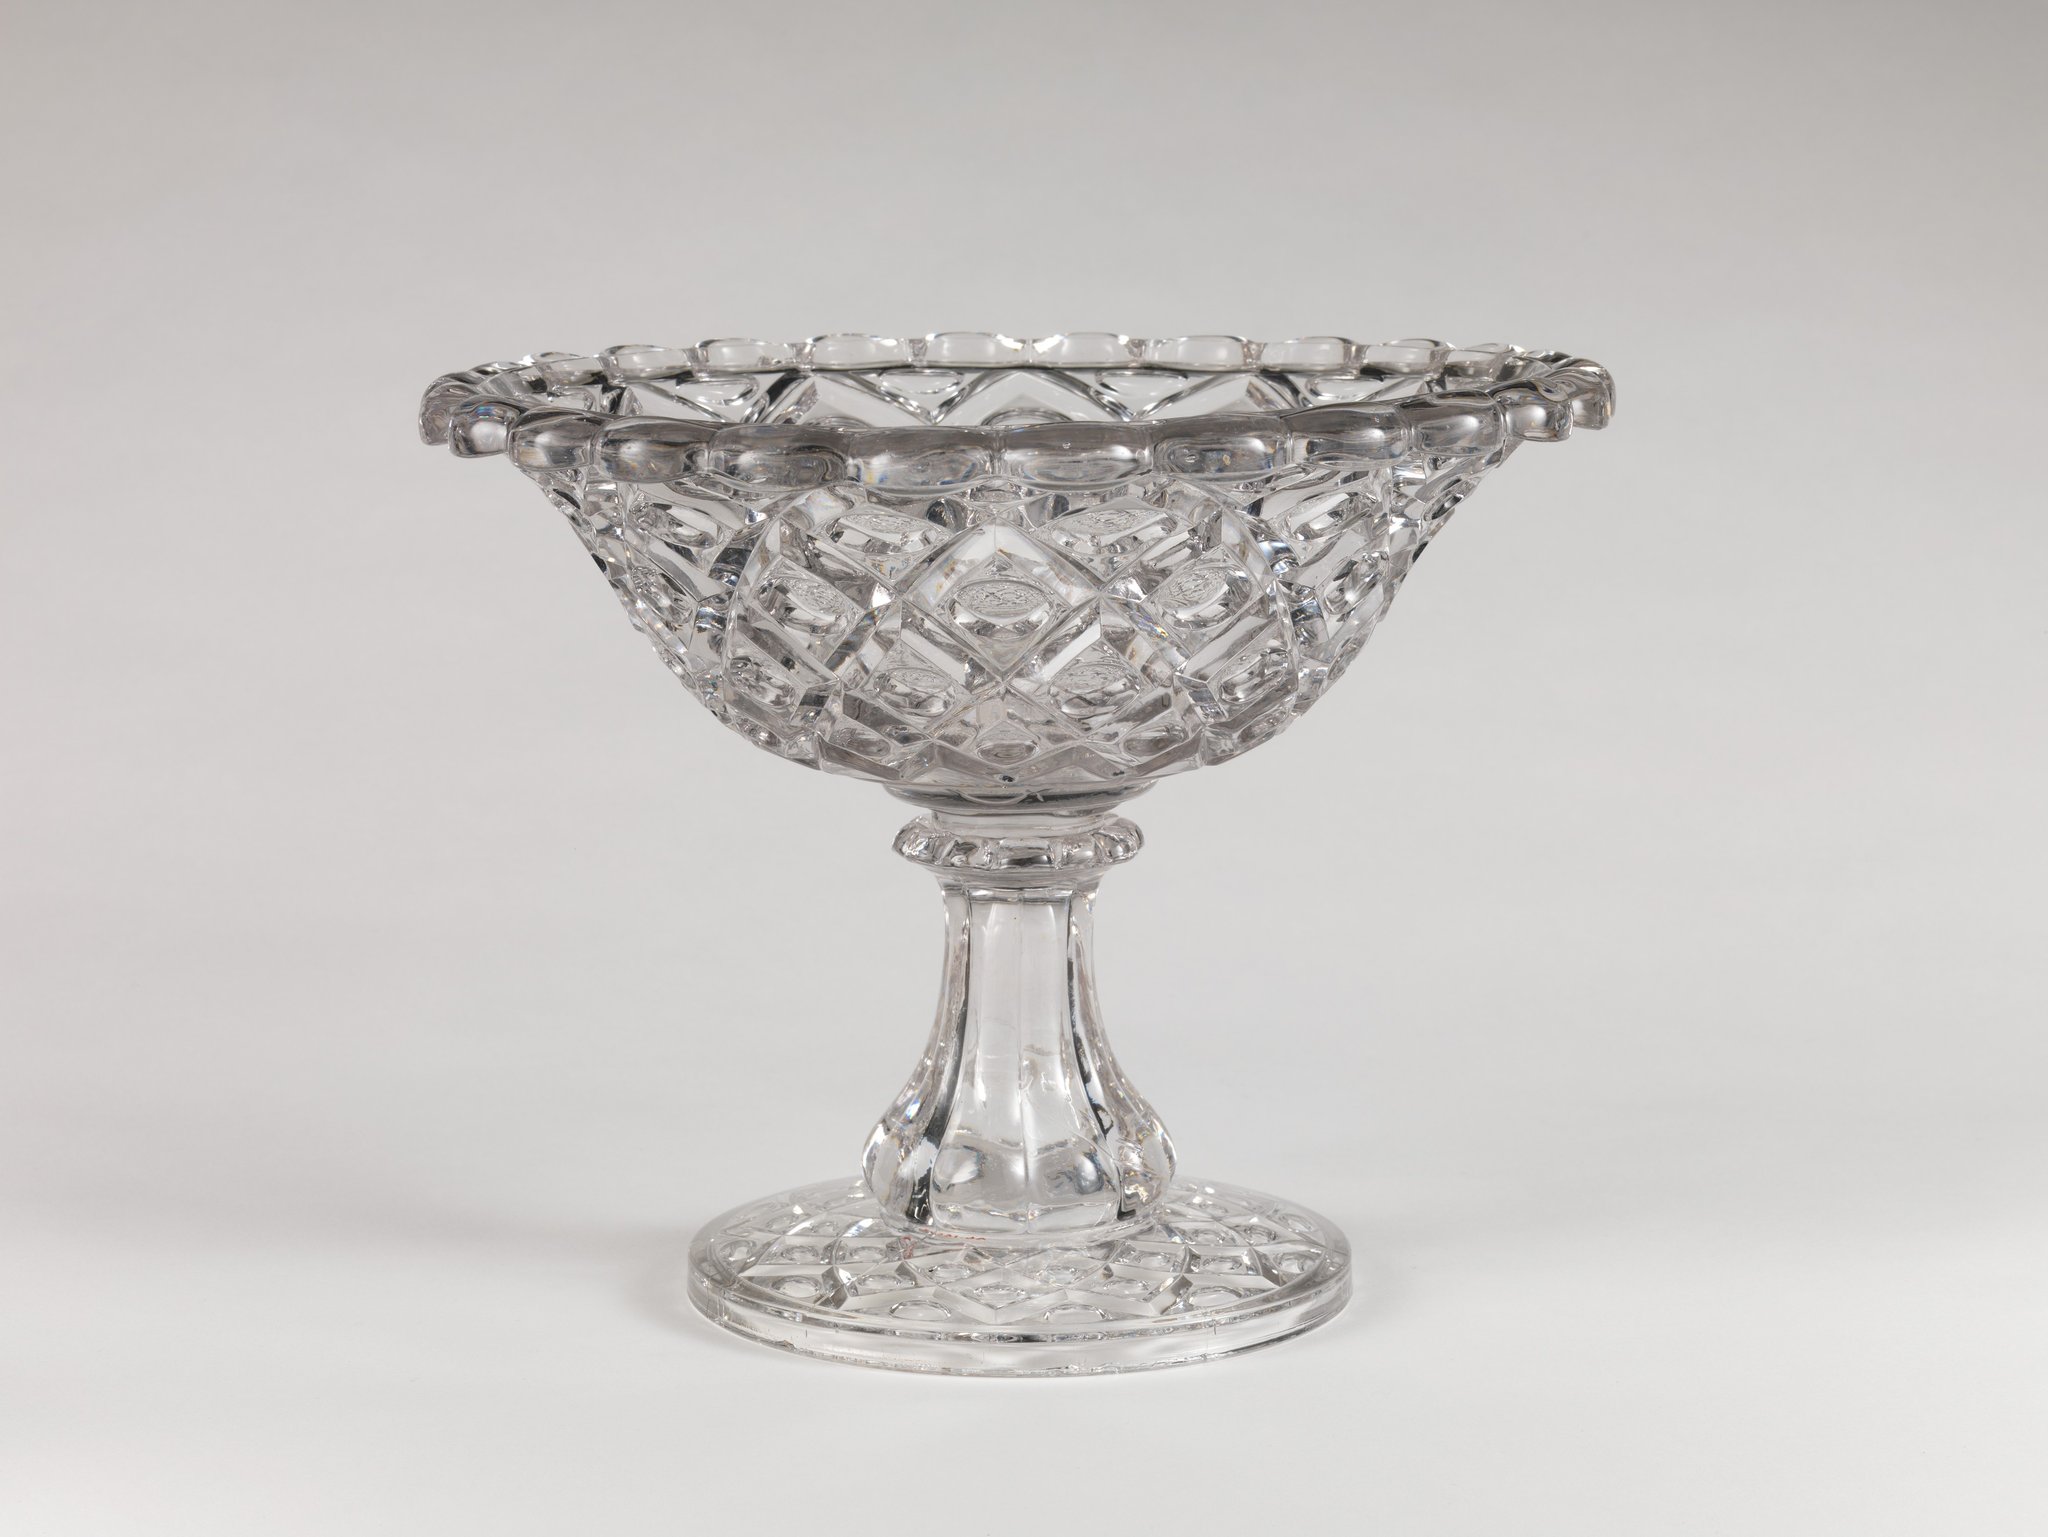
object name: compote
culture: american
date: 1850-1870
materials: glass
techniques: pressed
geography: united states